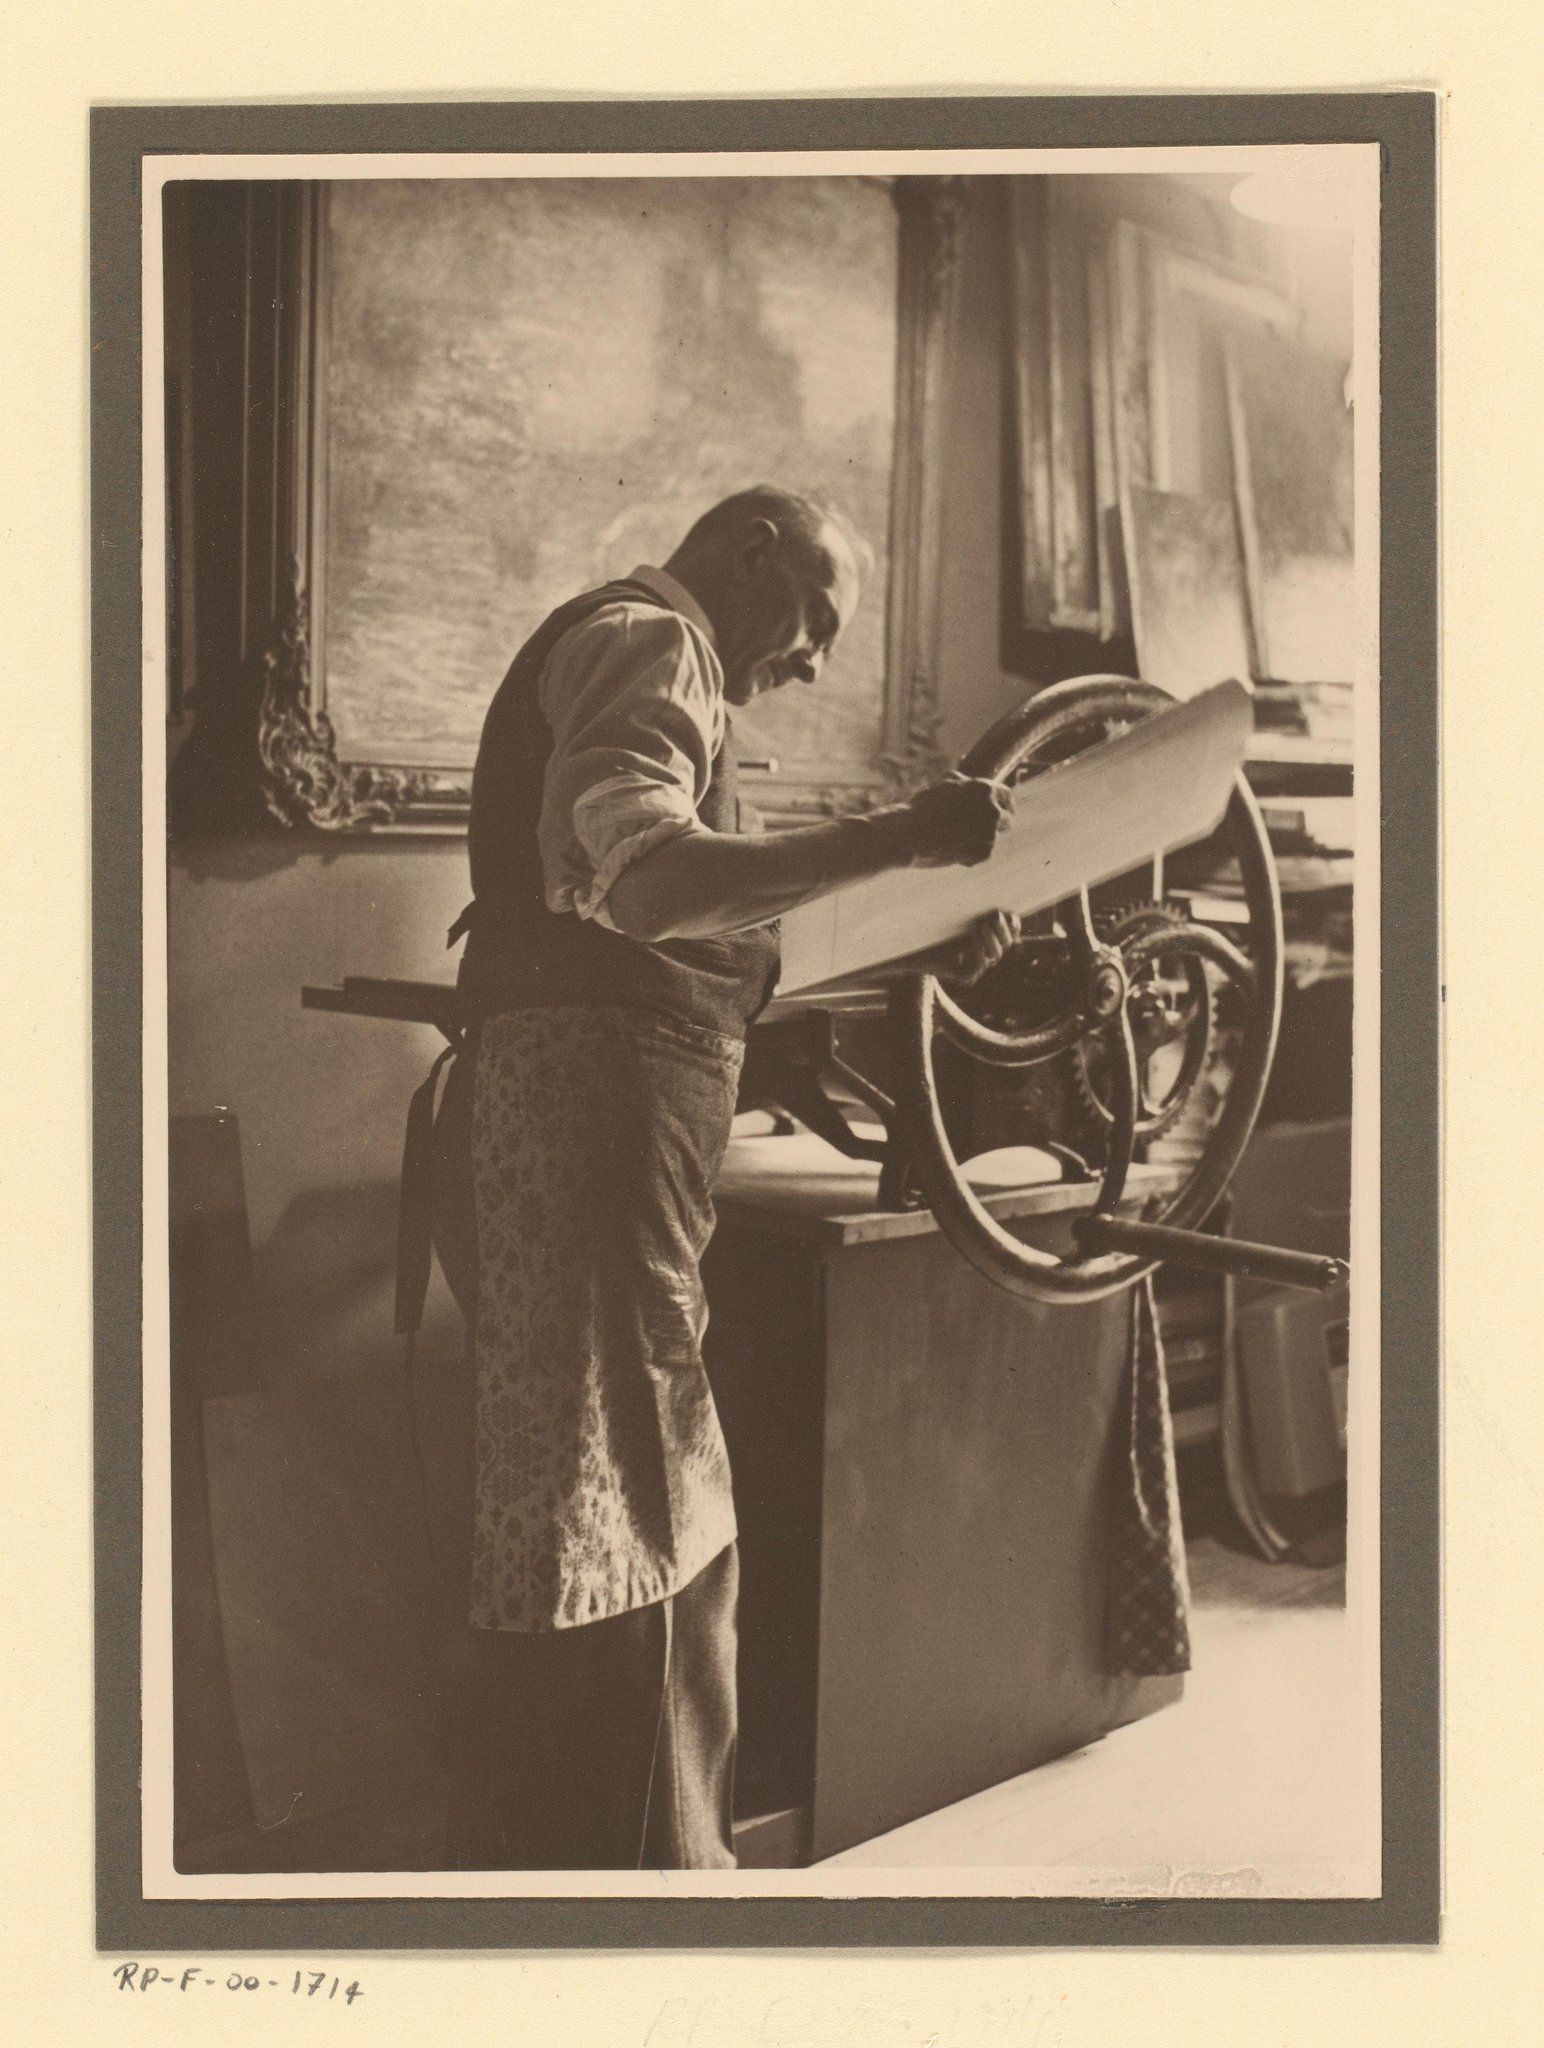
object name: photograph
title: Willem Adrianus Grondhout bij een handpers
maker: Anonymous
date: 1910-1934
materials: paper, cardboard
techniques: gelatin silver print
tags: the hague, painter, print maker, draughtsman, willem adrianus grondhout, historical persons, tools, implements of graphic artist, portrait, self-portrait of graphic artist